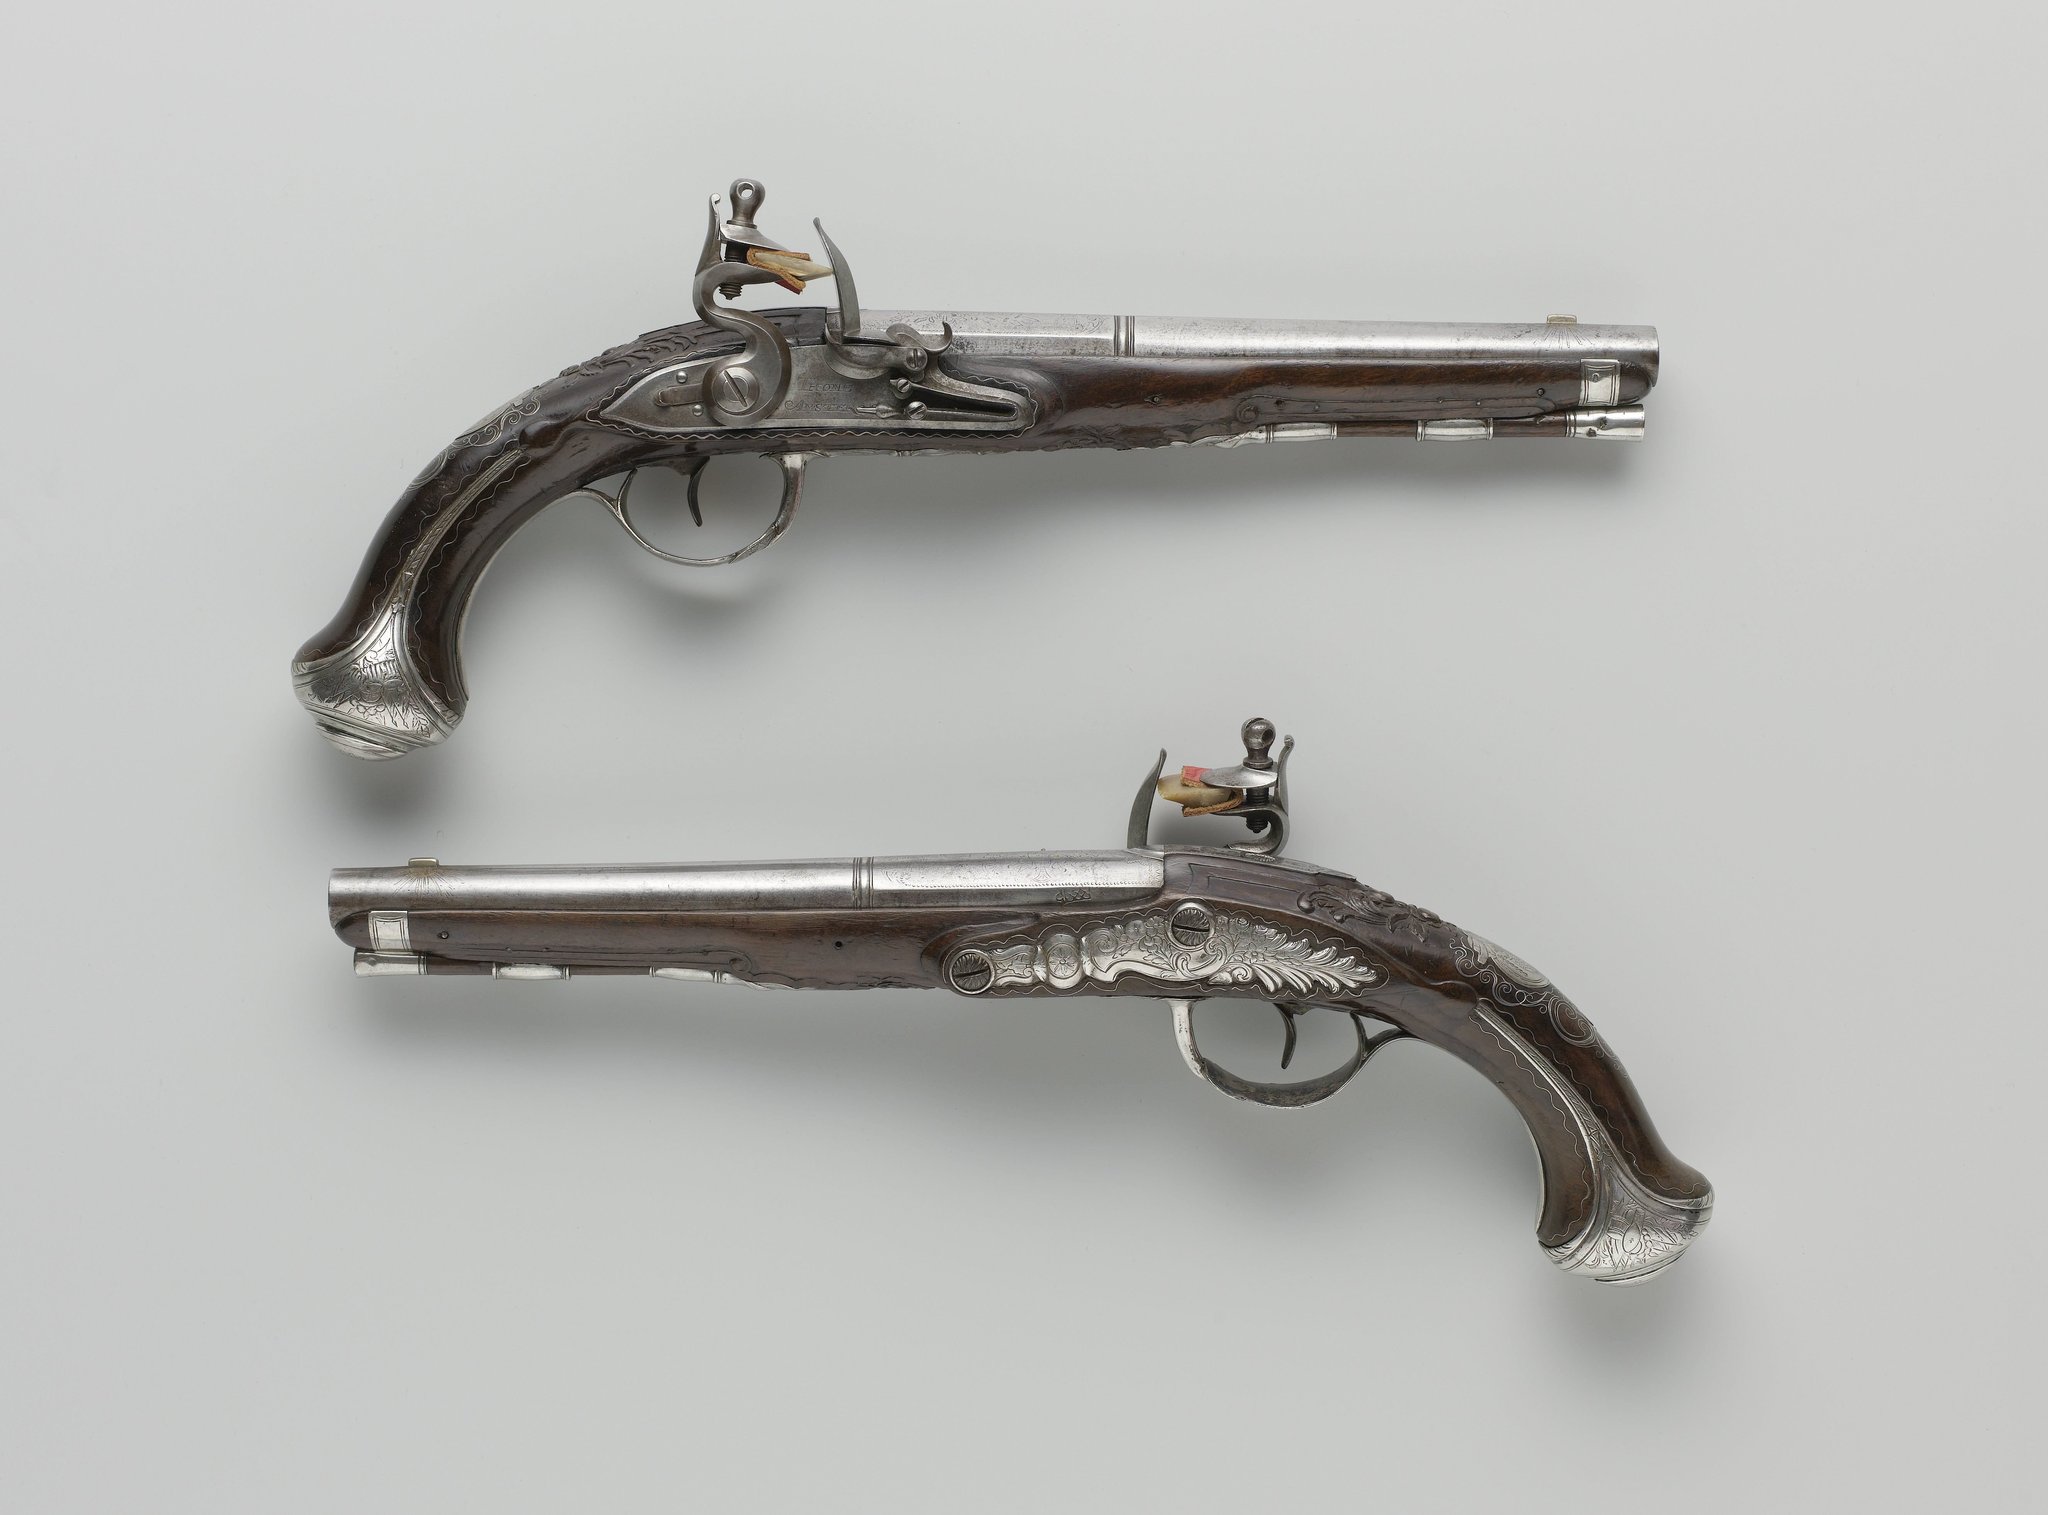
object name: flintlock pistol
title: Vuursteenpistool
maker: lambertus michaelis thone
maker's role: weapon manufacturer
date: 1780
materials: gold, silver, thread, wood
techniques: printing, metalworking, cutting, encrustation, engraving, filing, inlay, striking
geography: amsterdam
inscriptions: coat of arms, signature: ‘THONE // AMSTERDAM’, mark: ‘V’, coat of arms